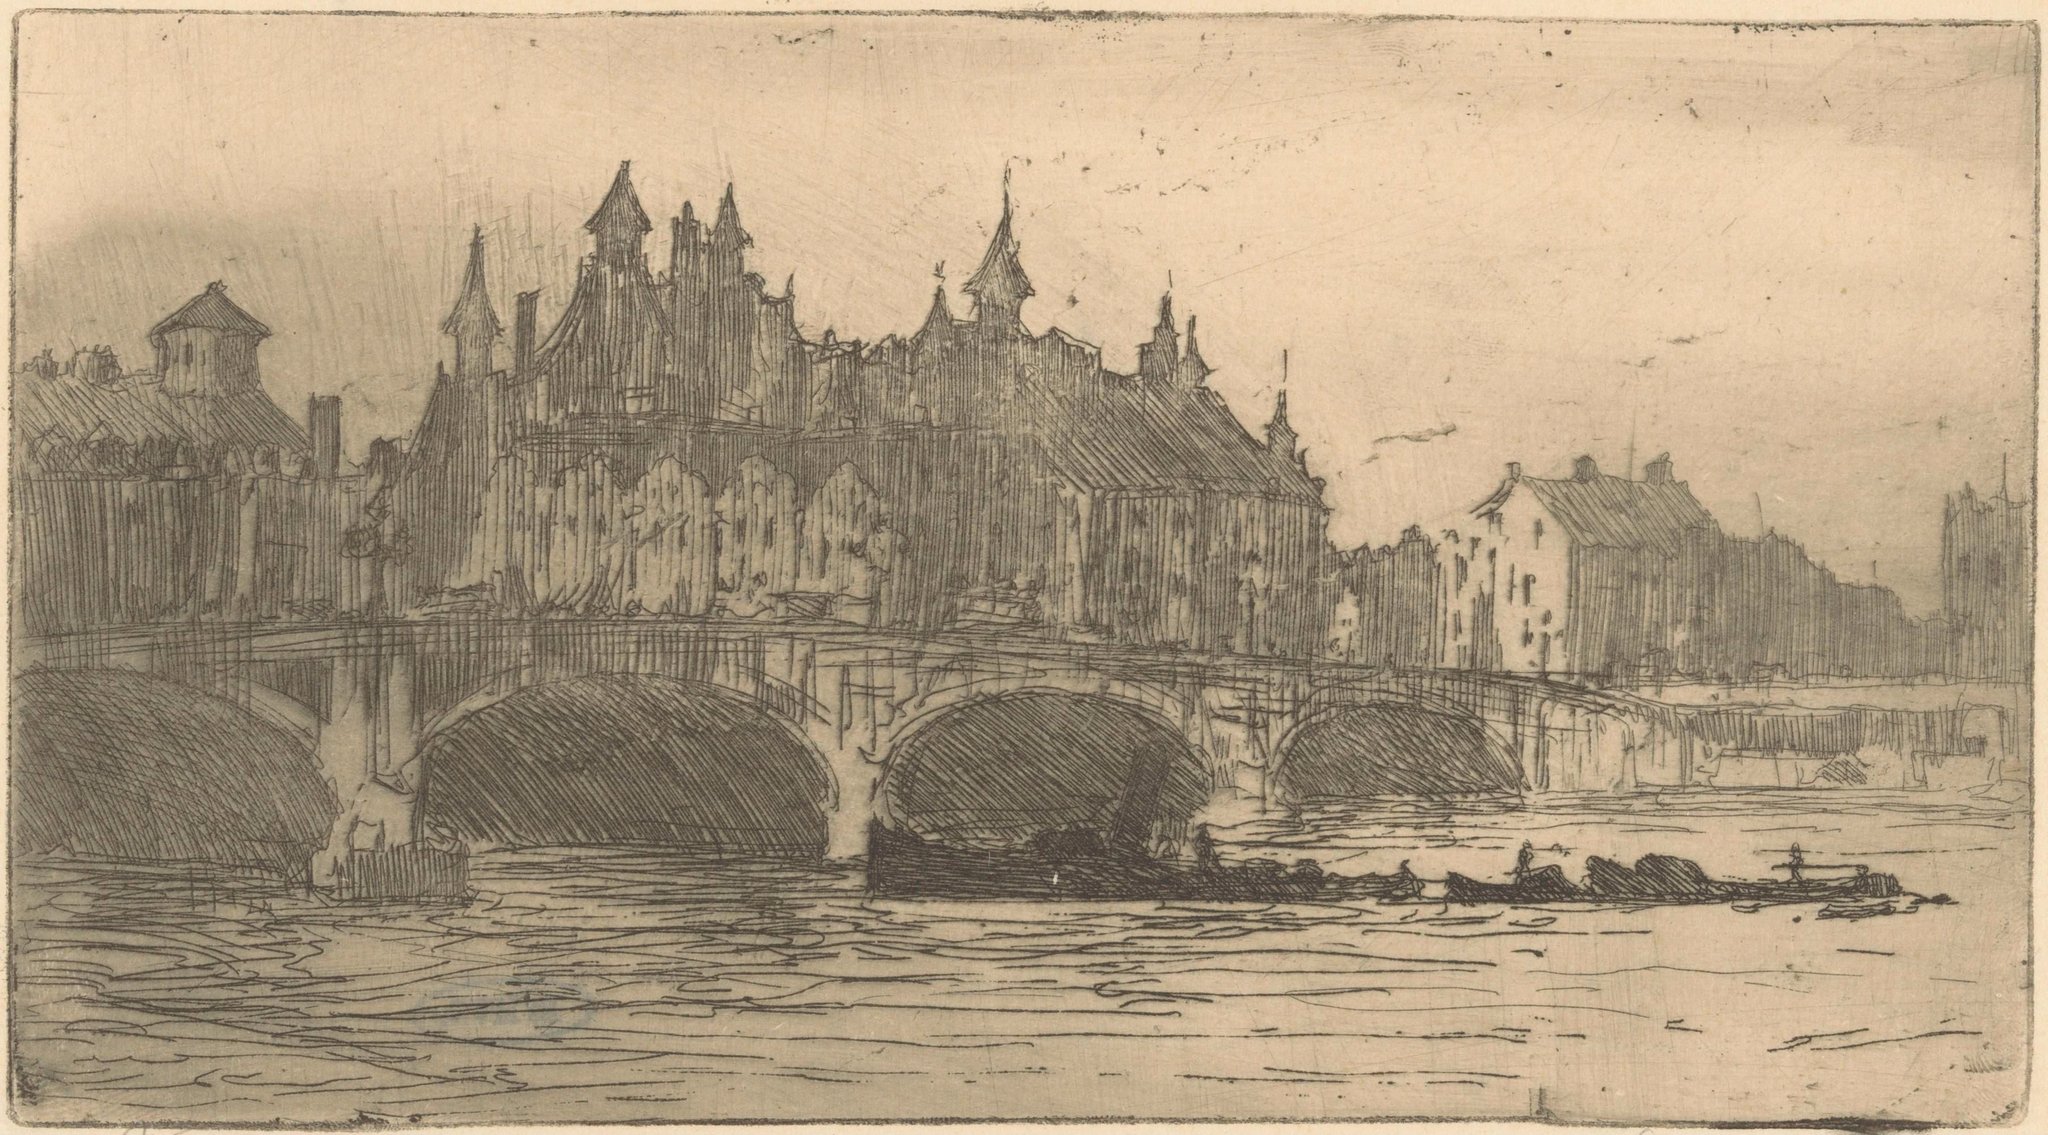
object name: print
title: Londen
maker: willem adrianus grondhout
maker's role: draughtsman, painter, print maker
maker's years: 1878-1934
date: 1888-1934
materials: paper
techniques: etching, intaglio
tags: bridge in city across river, canal, etc., london, thames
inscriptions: collector's mark: Lugt 2228